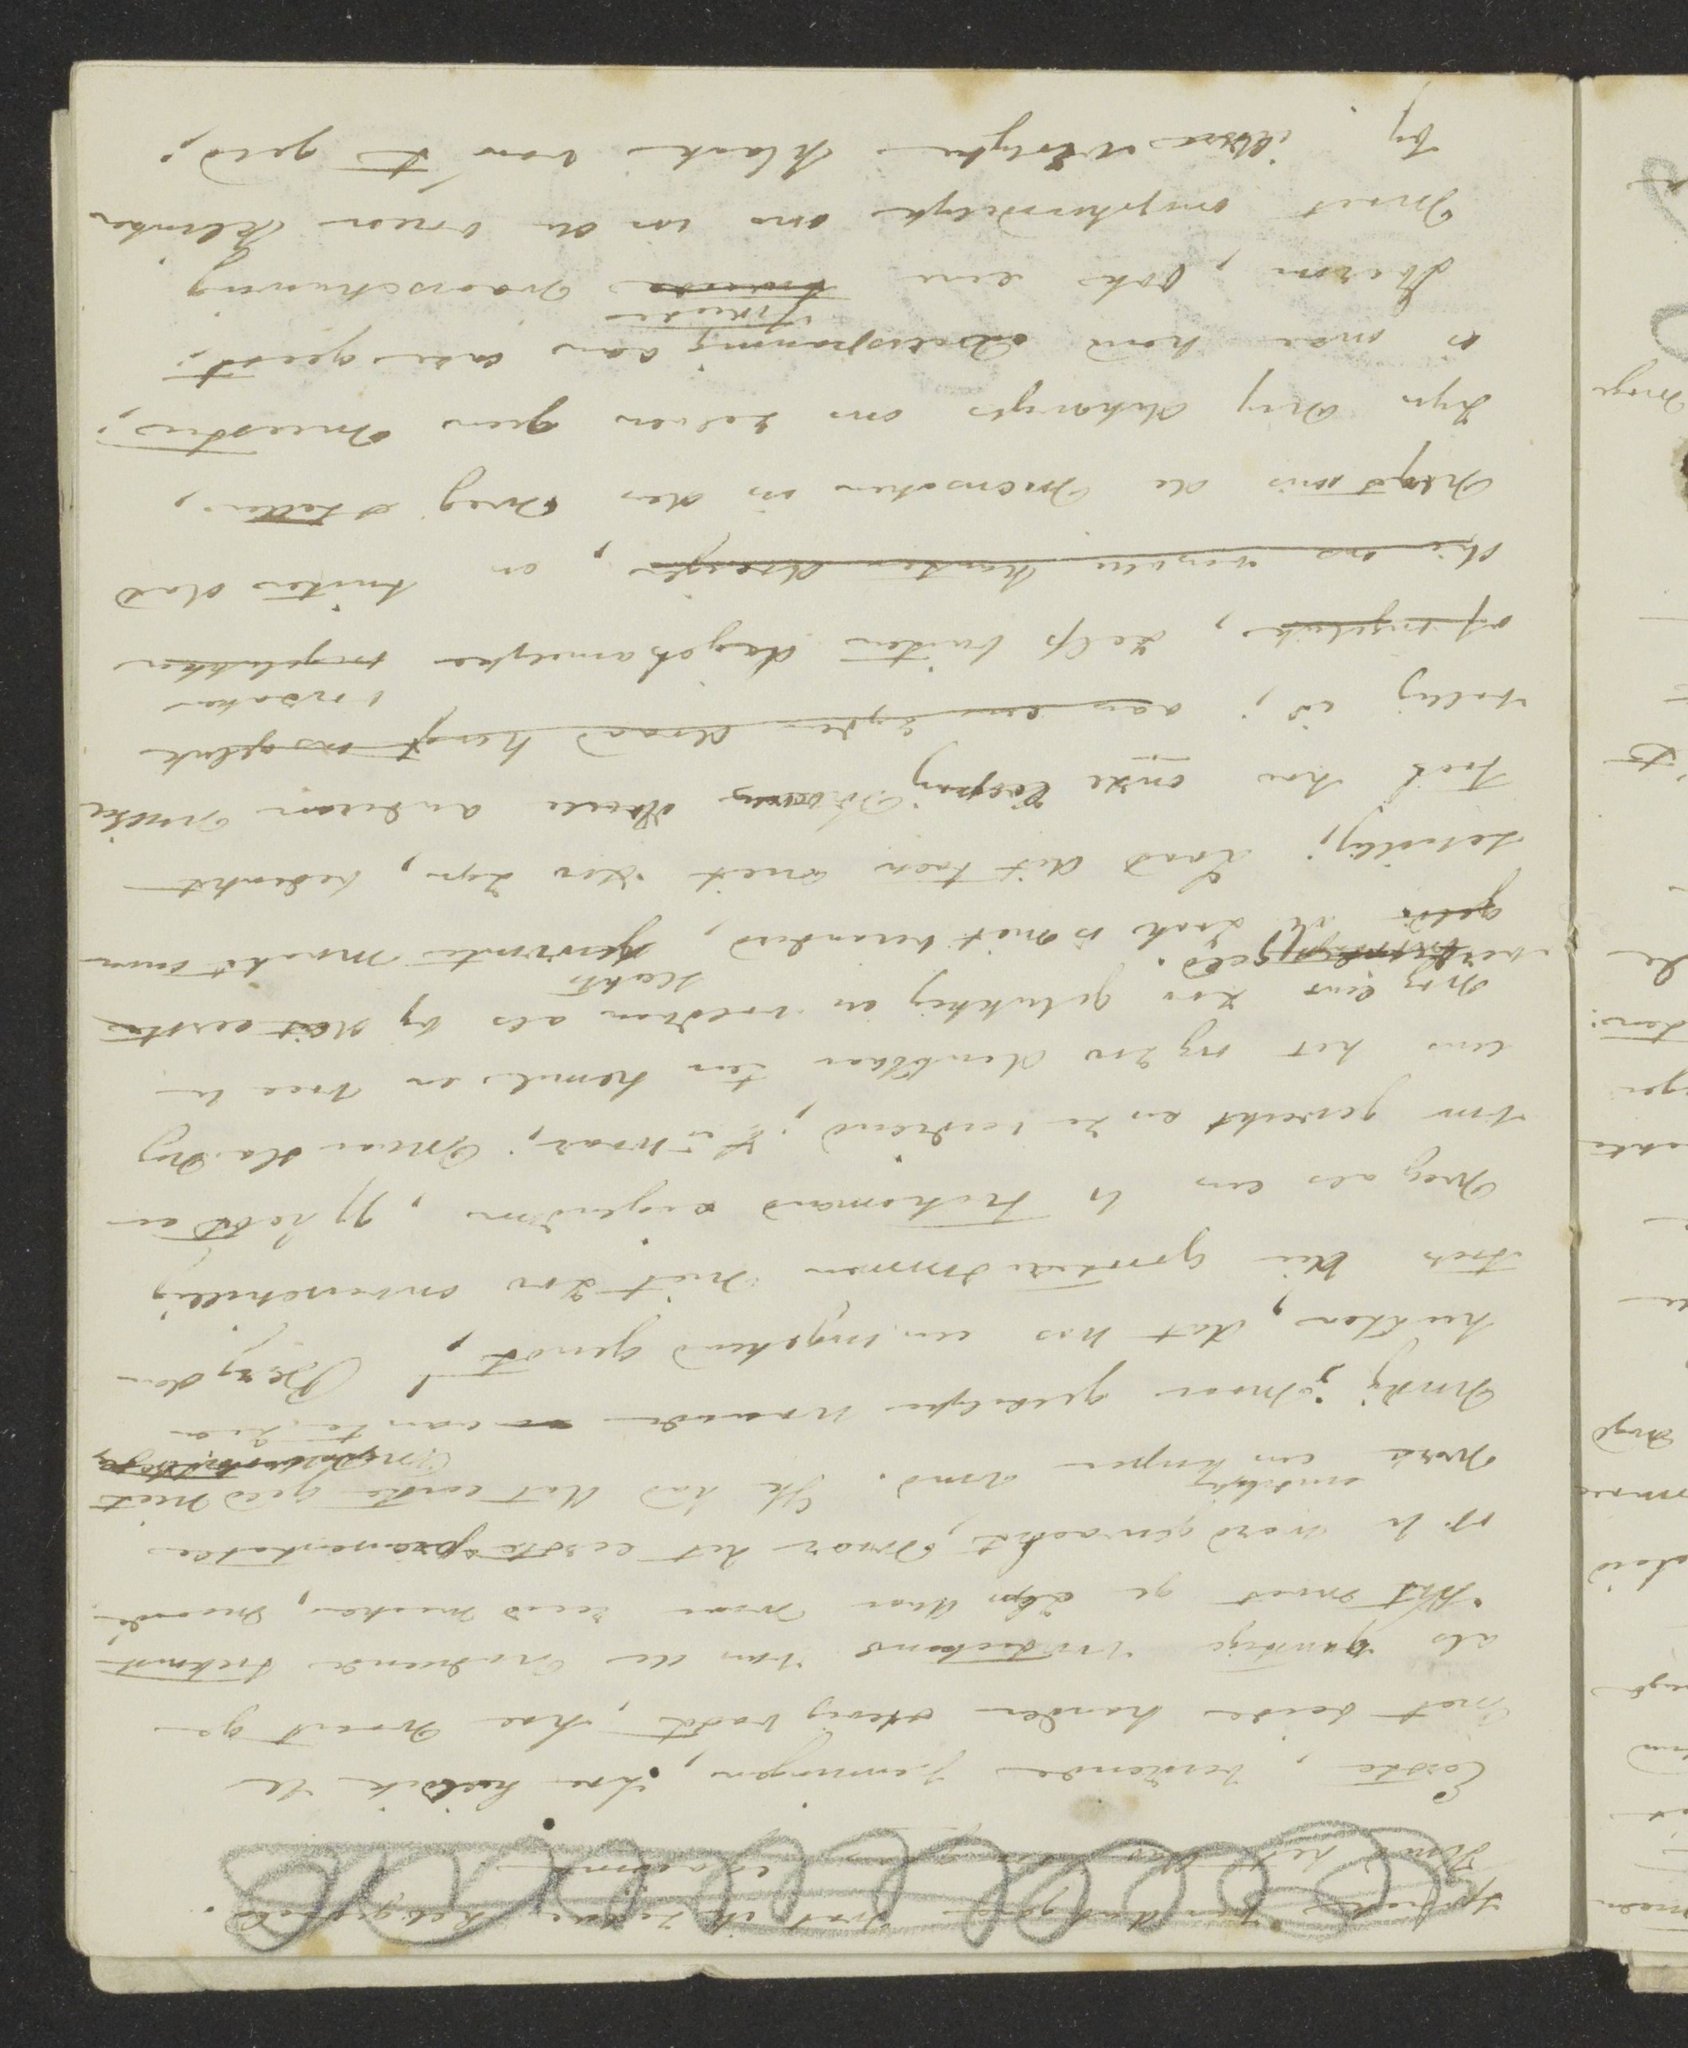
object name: sketchbook leaf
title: Notities, deels doorgehaald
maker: maria vos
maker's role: draughtsman, painter, print maker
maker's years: 1824-1906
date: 1834-1906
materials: ink, paper, pencil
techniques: pen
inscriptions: annotation: ‘[...]’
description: Blad 11 verso uit een schetsboek met 17 bladen.